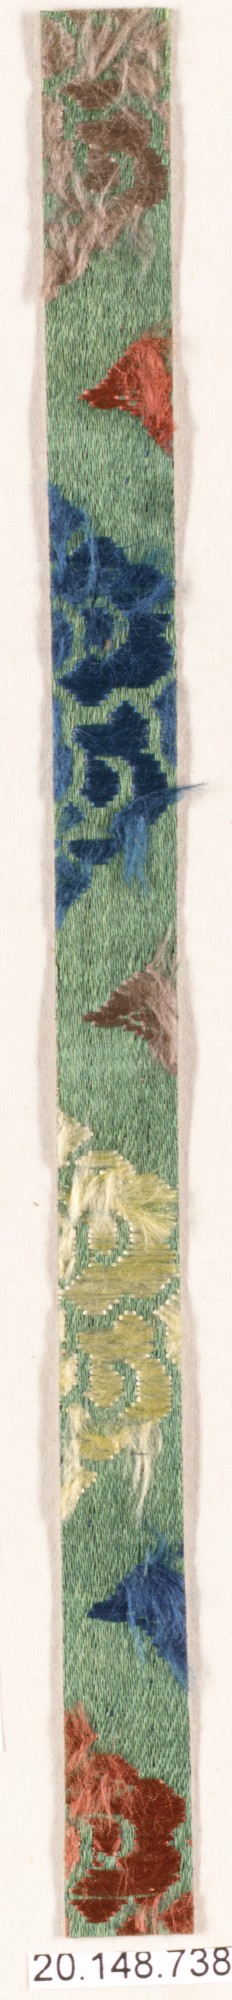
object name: piece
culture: japanese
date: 1601-1700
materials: silk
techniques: compound weave